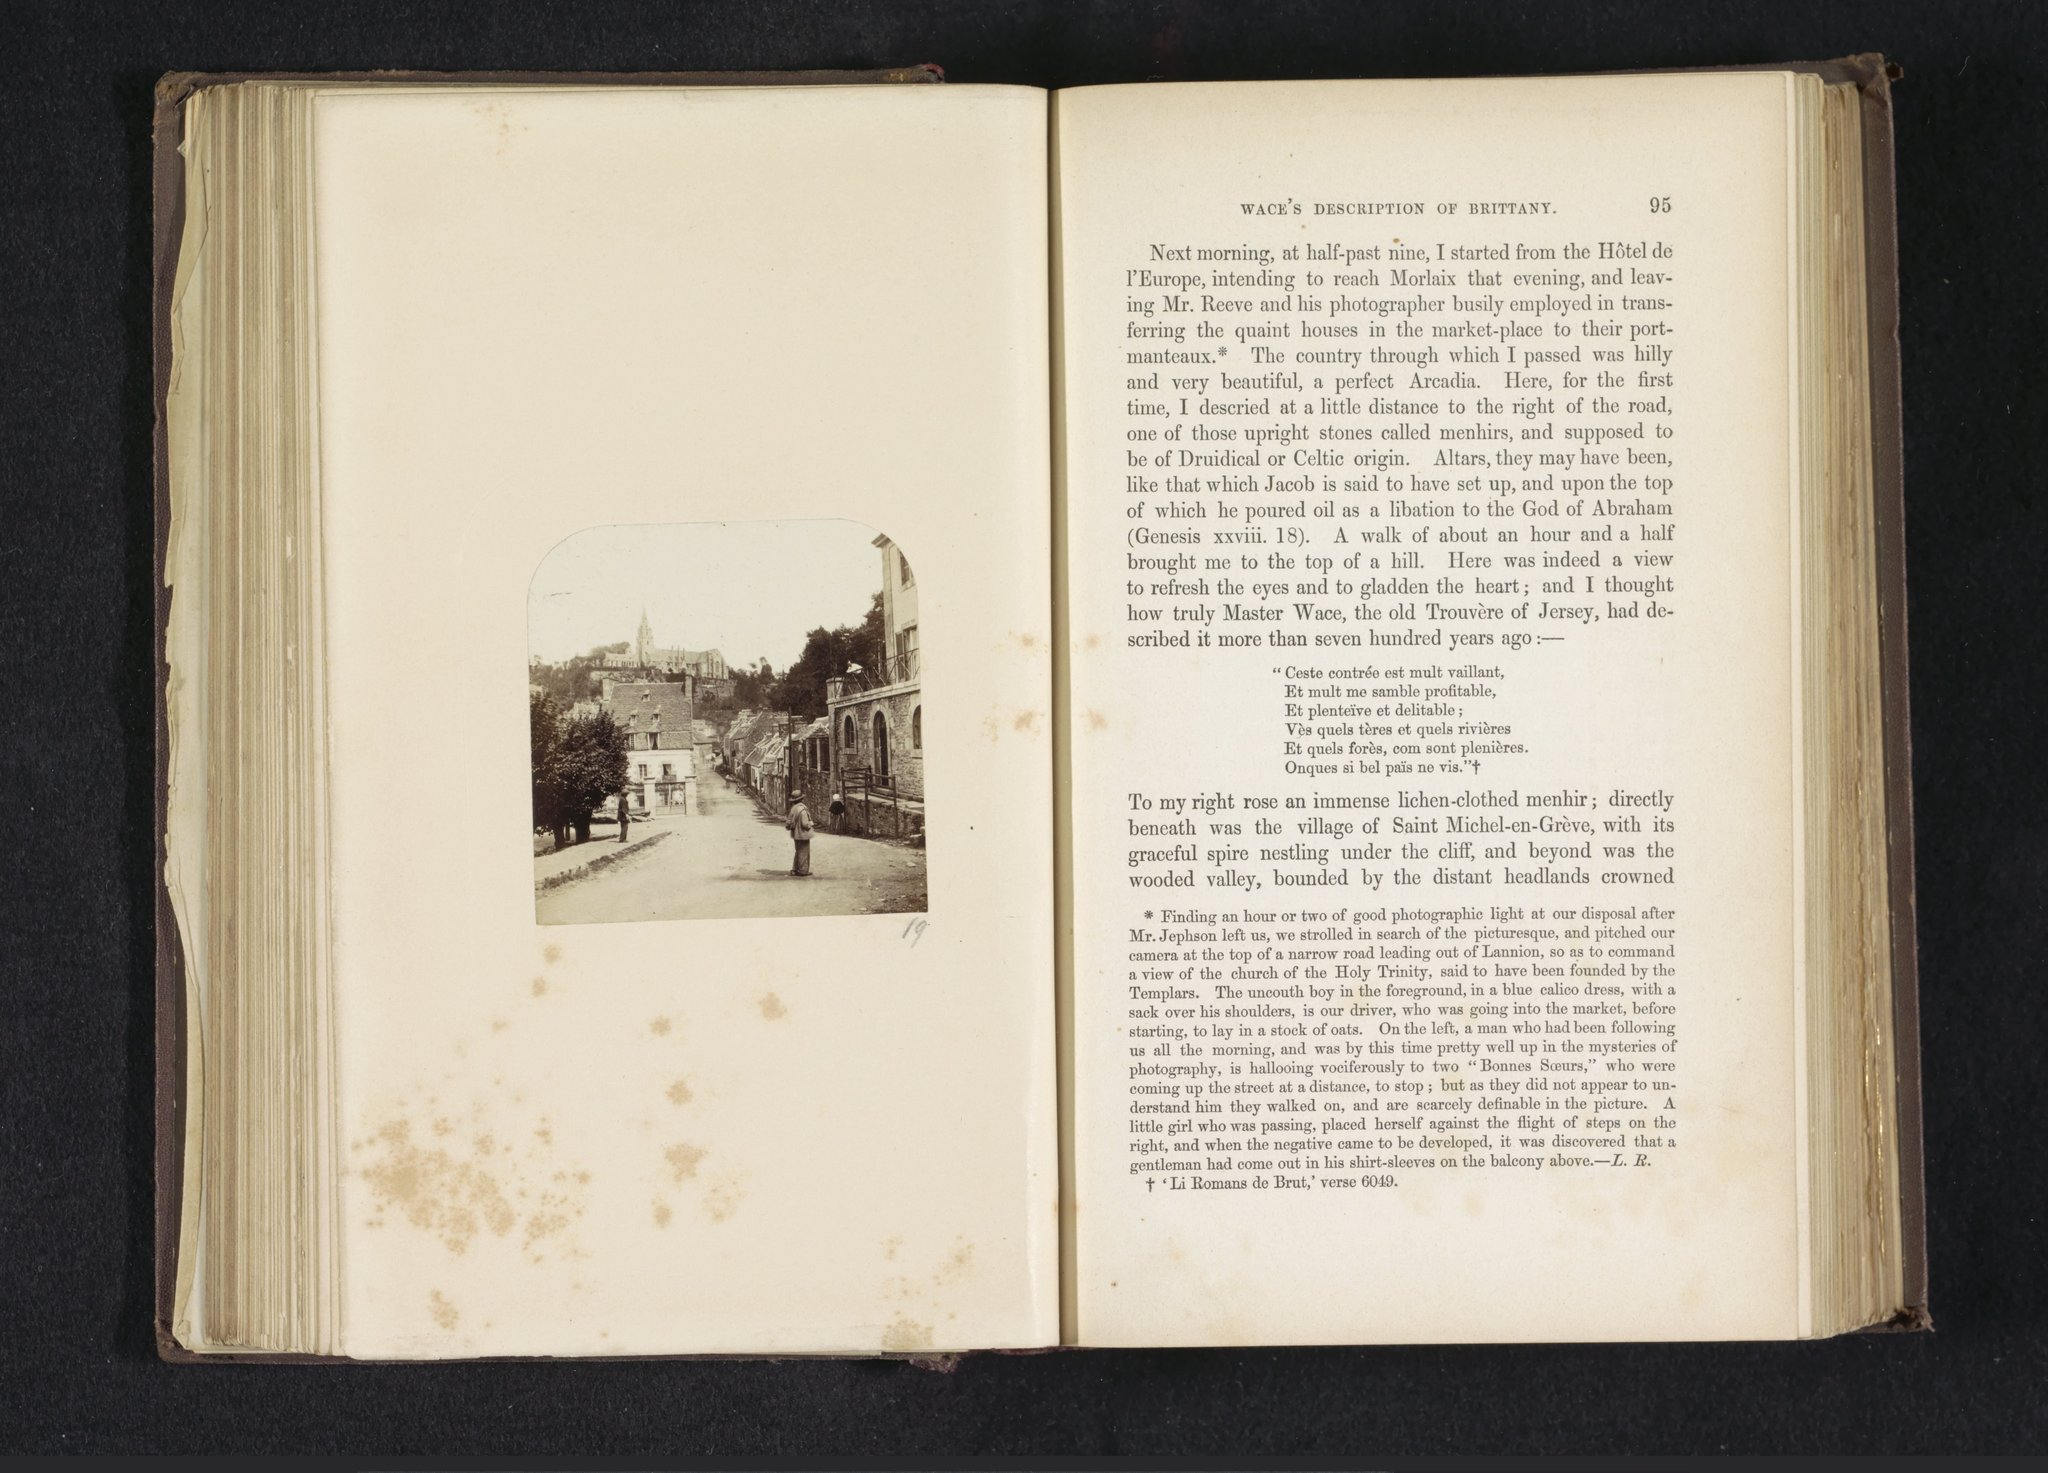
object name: page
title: Straat en Kerk van de Heilige Drie-eenheid in Lannion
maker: taylor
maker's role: fotograaf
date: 1850-1859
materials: photographic support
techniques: albumen print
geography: lannion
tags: church (exterior), street (+ city(-scape) with figures, staffage)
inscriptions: number: ‘19’